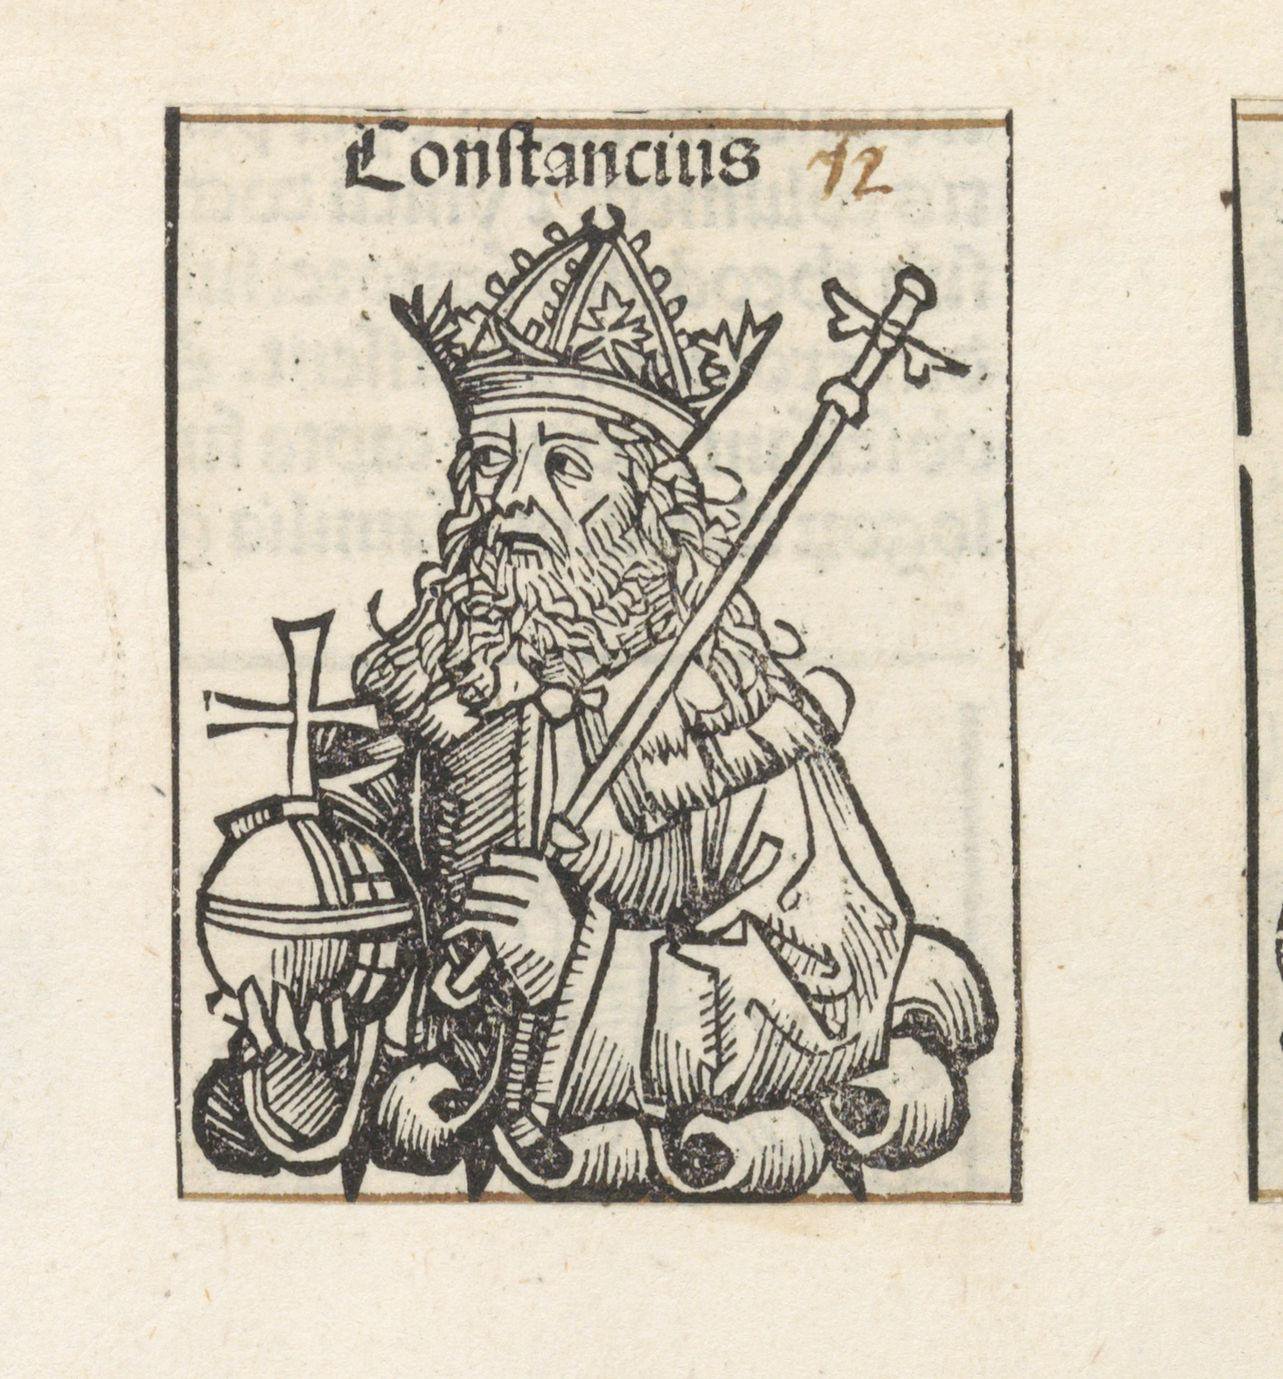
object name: print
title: Keizer Constantius II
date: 1493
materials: paper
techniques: letterpress printing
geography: nuremberg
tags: emperor, king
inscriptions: inscription: ‘12’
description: Een bloemkelk met een koning, naar links gekeerd. Hij heeft een scepter en rijksappel in zijn handen. De voorstelling is onderdeel van de opeenvolging Romeinse keizers in de Liber Chronicarum. De tekst identificeert de man als keizer Constantius II. De prent maakt deel uit van een album.